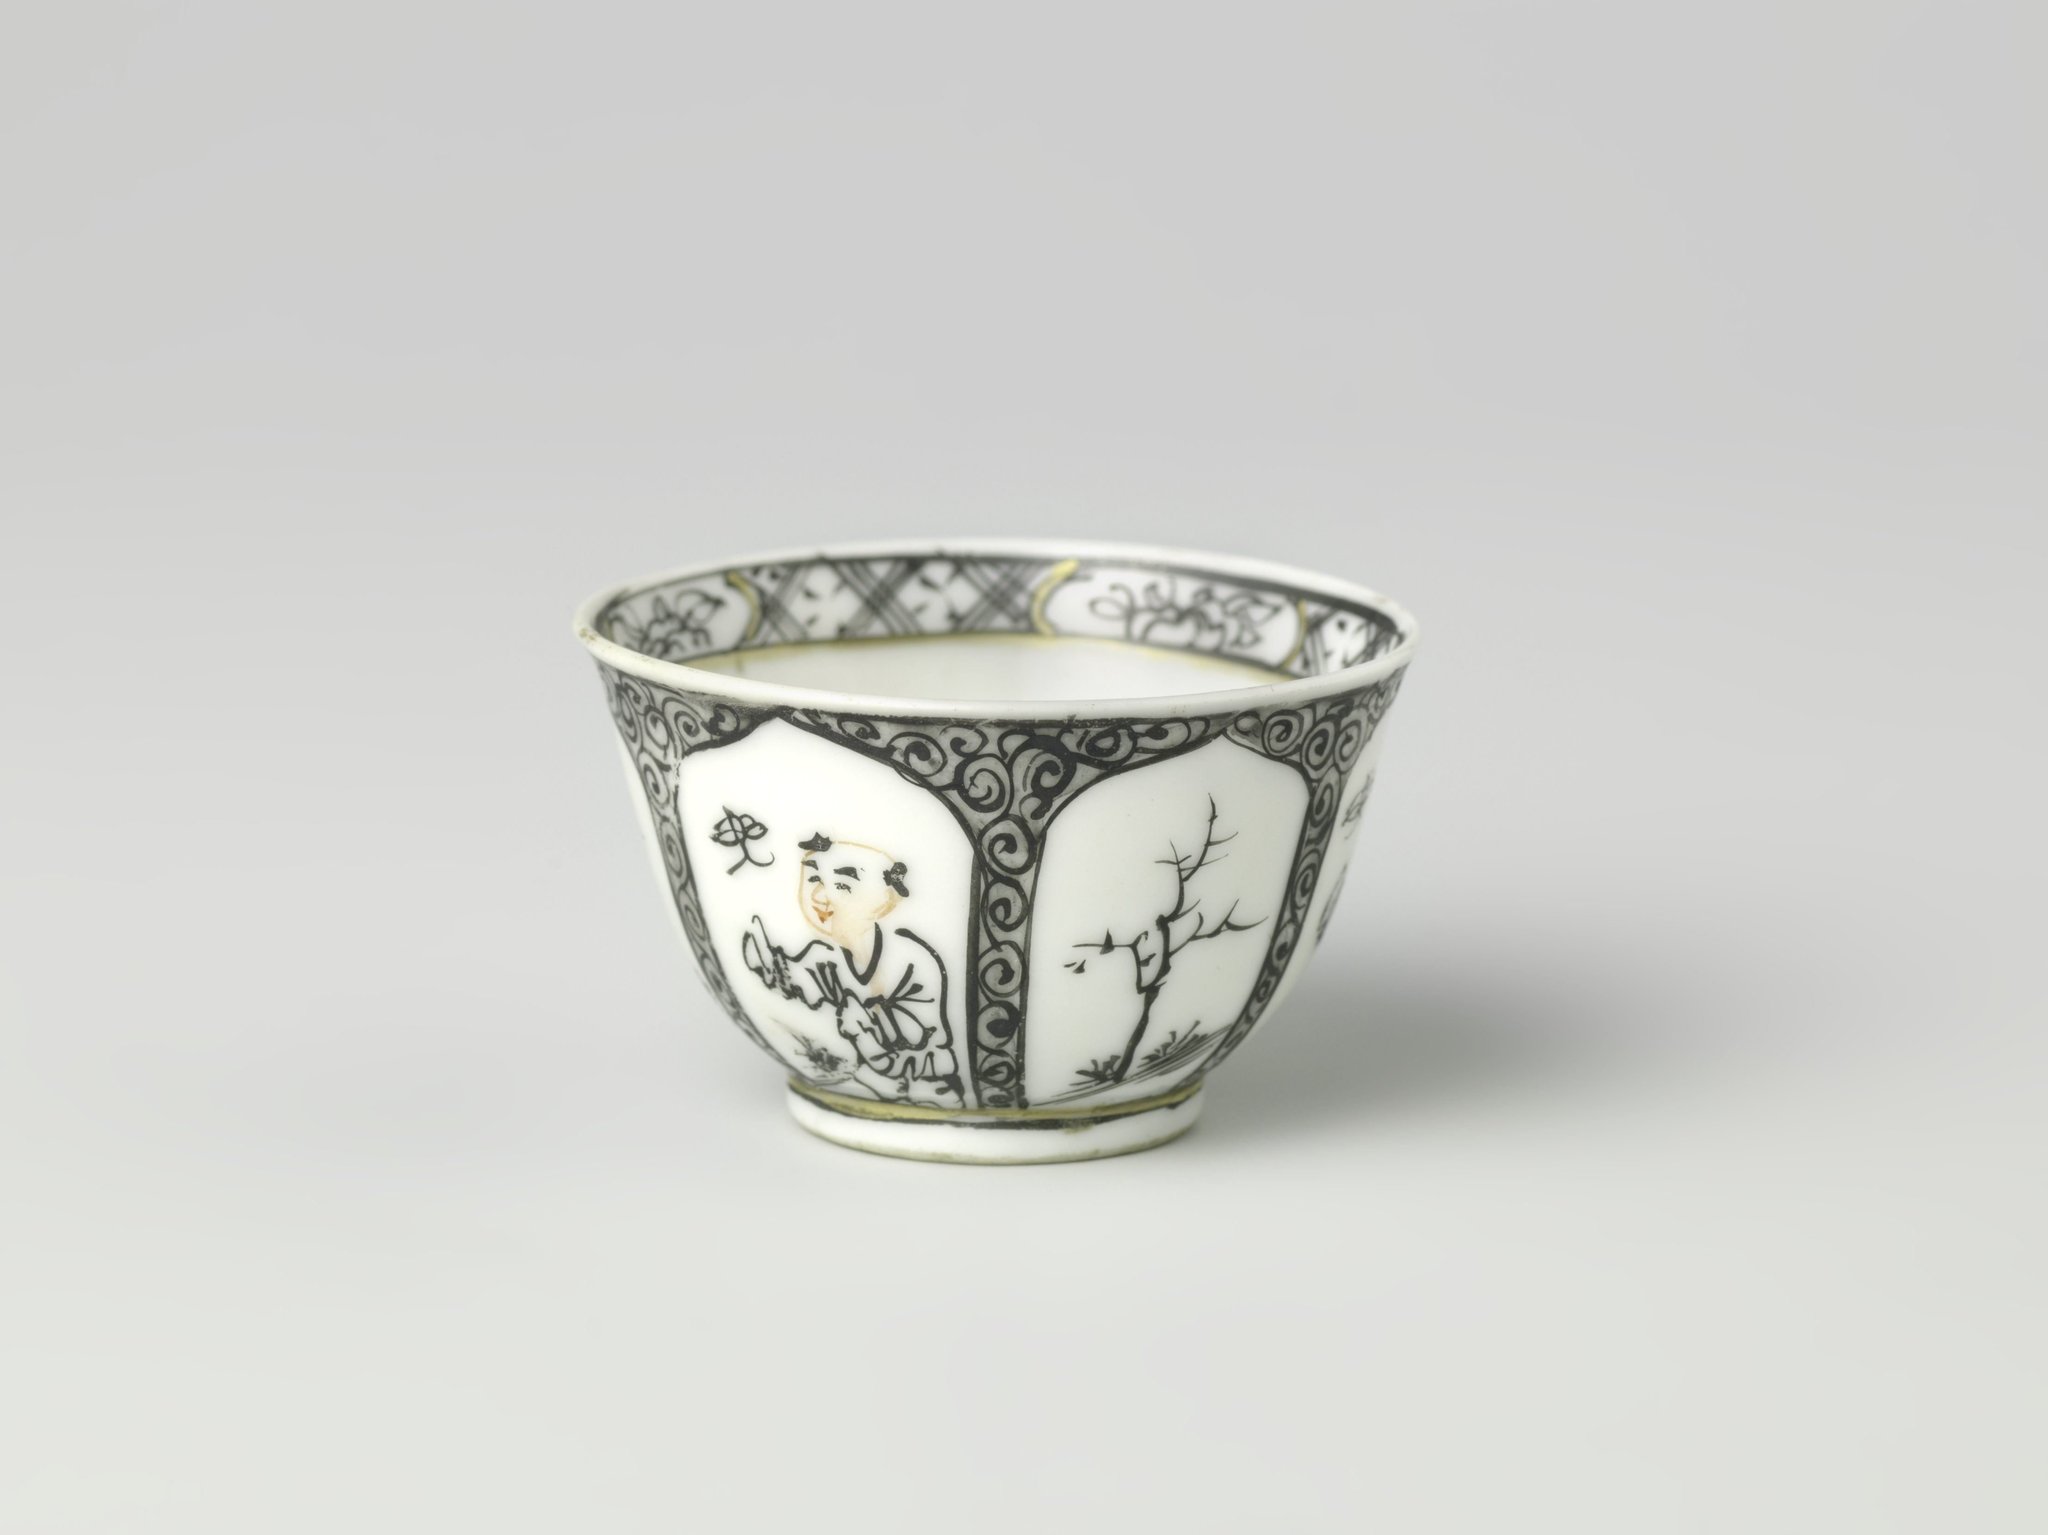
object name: kop en schotel, kop en schotel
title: Cup with a boy and a butterfly in a landscape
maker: Anonymous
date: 1725-1749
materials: glaze, gold, paint, porcelain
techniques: firing, gilding, turning, vitrification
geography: china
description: Kop en schotel, in zwart ,rose en goud met chinezen en bomen in perken.